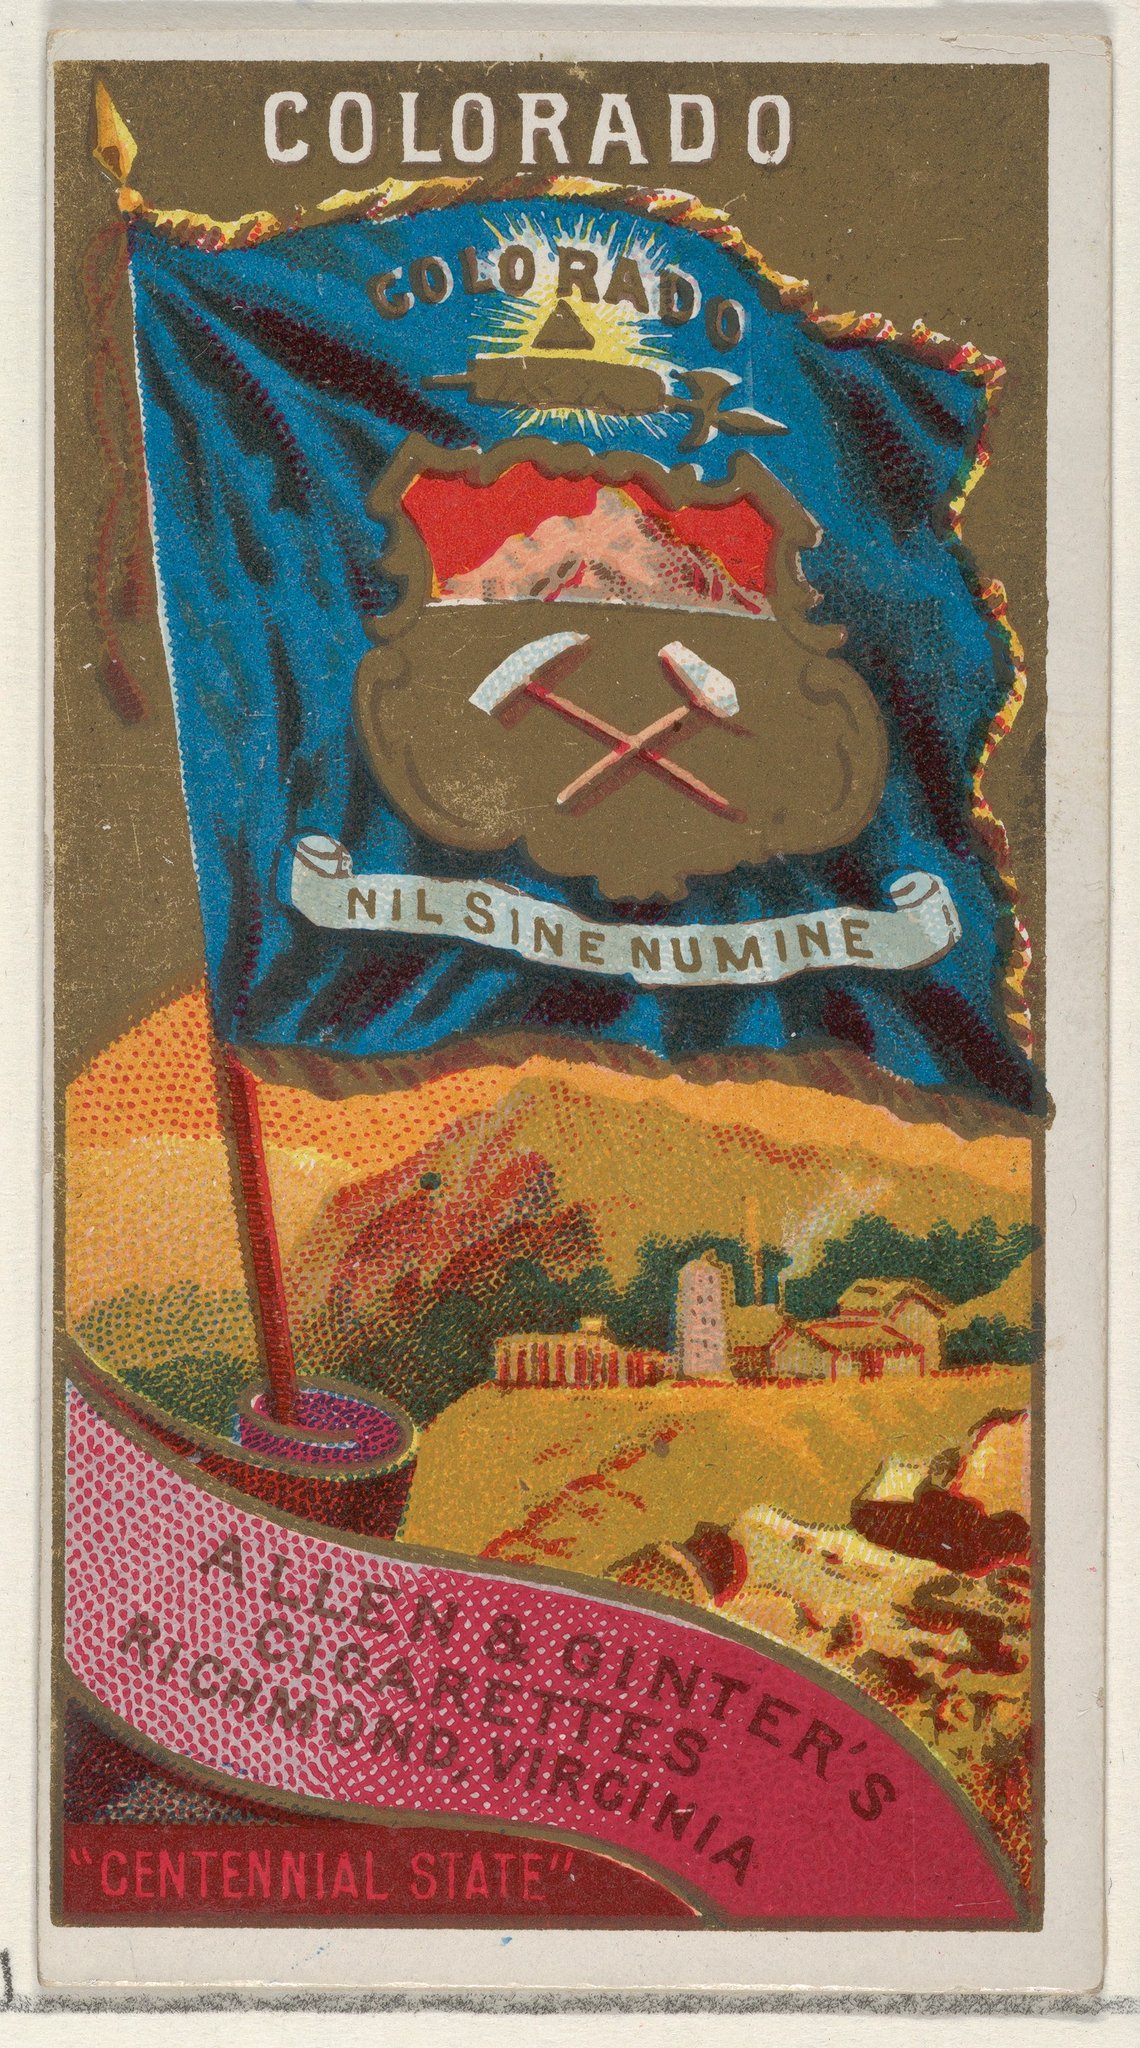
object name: print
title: Colorado, from Flags of the States and Territories (N11) for Allen & Ginter Cigarettes Brands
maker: allen & ginter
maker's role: publisher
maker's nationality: american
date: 1888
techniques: color lithograph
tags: coat of arms,flags